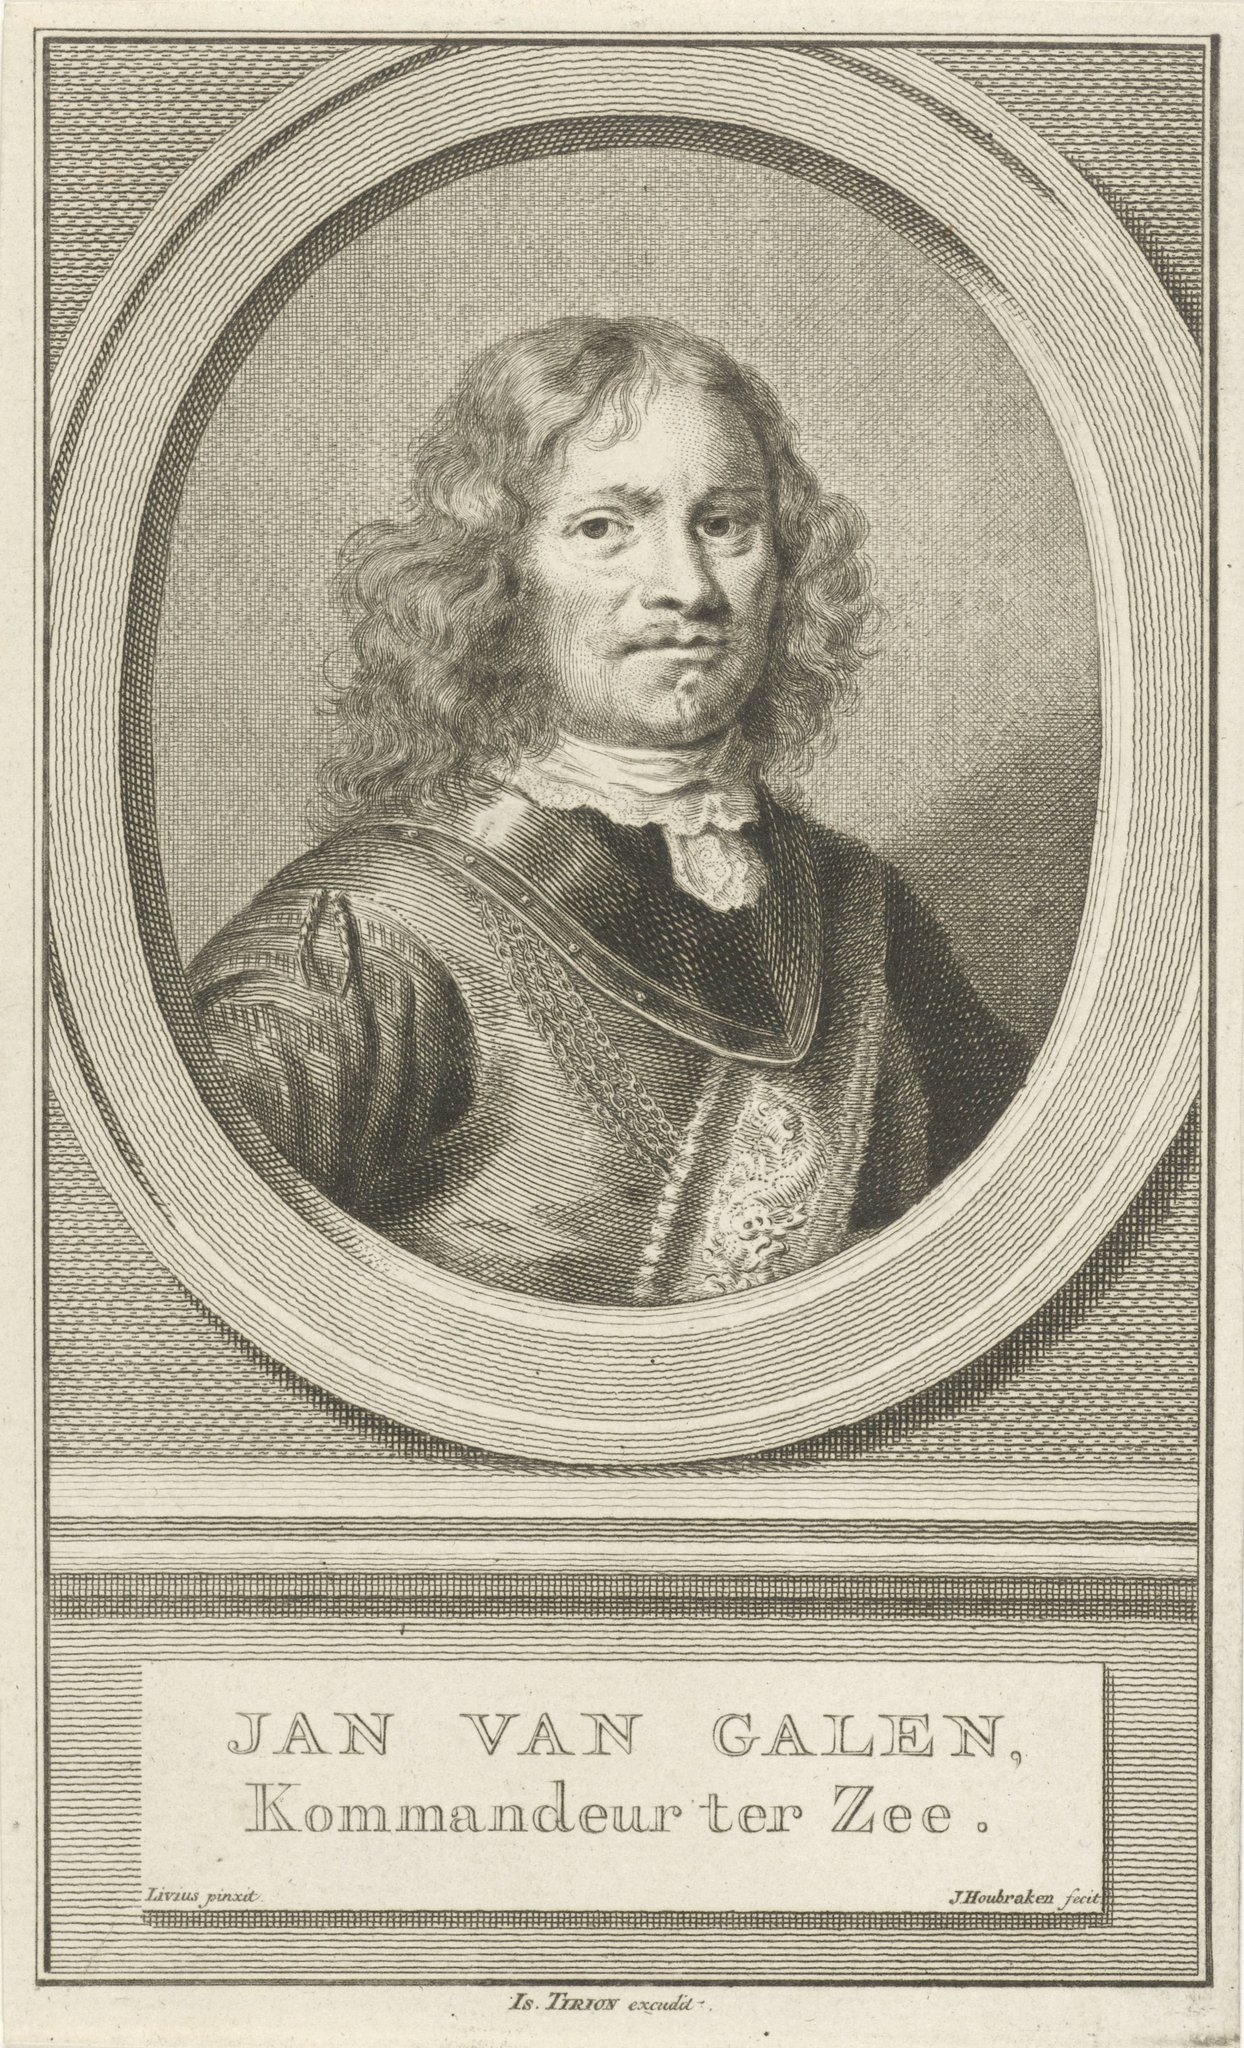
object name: print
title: Portret van Johan van Galen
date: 1749-1759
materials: paper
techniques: engraving, etching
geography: amsterdam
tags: livorno, vlootvoogd, jan van galen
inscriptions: collector's mark: Lugt 2228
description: Prent ook gebruikt in: Jan Wagenaar, Vaderlandsche historie, vervattende de geschiedenissen der nu Vereenigde Nederlanden, inzonderheid die van Holland (...), 21 delen. Amsterdam, Isaak Tirion, 1749-59.